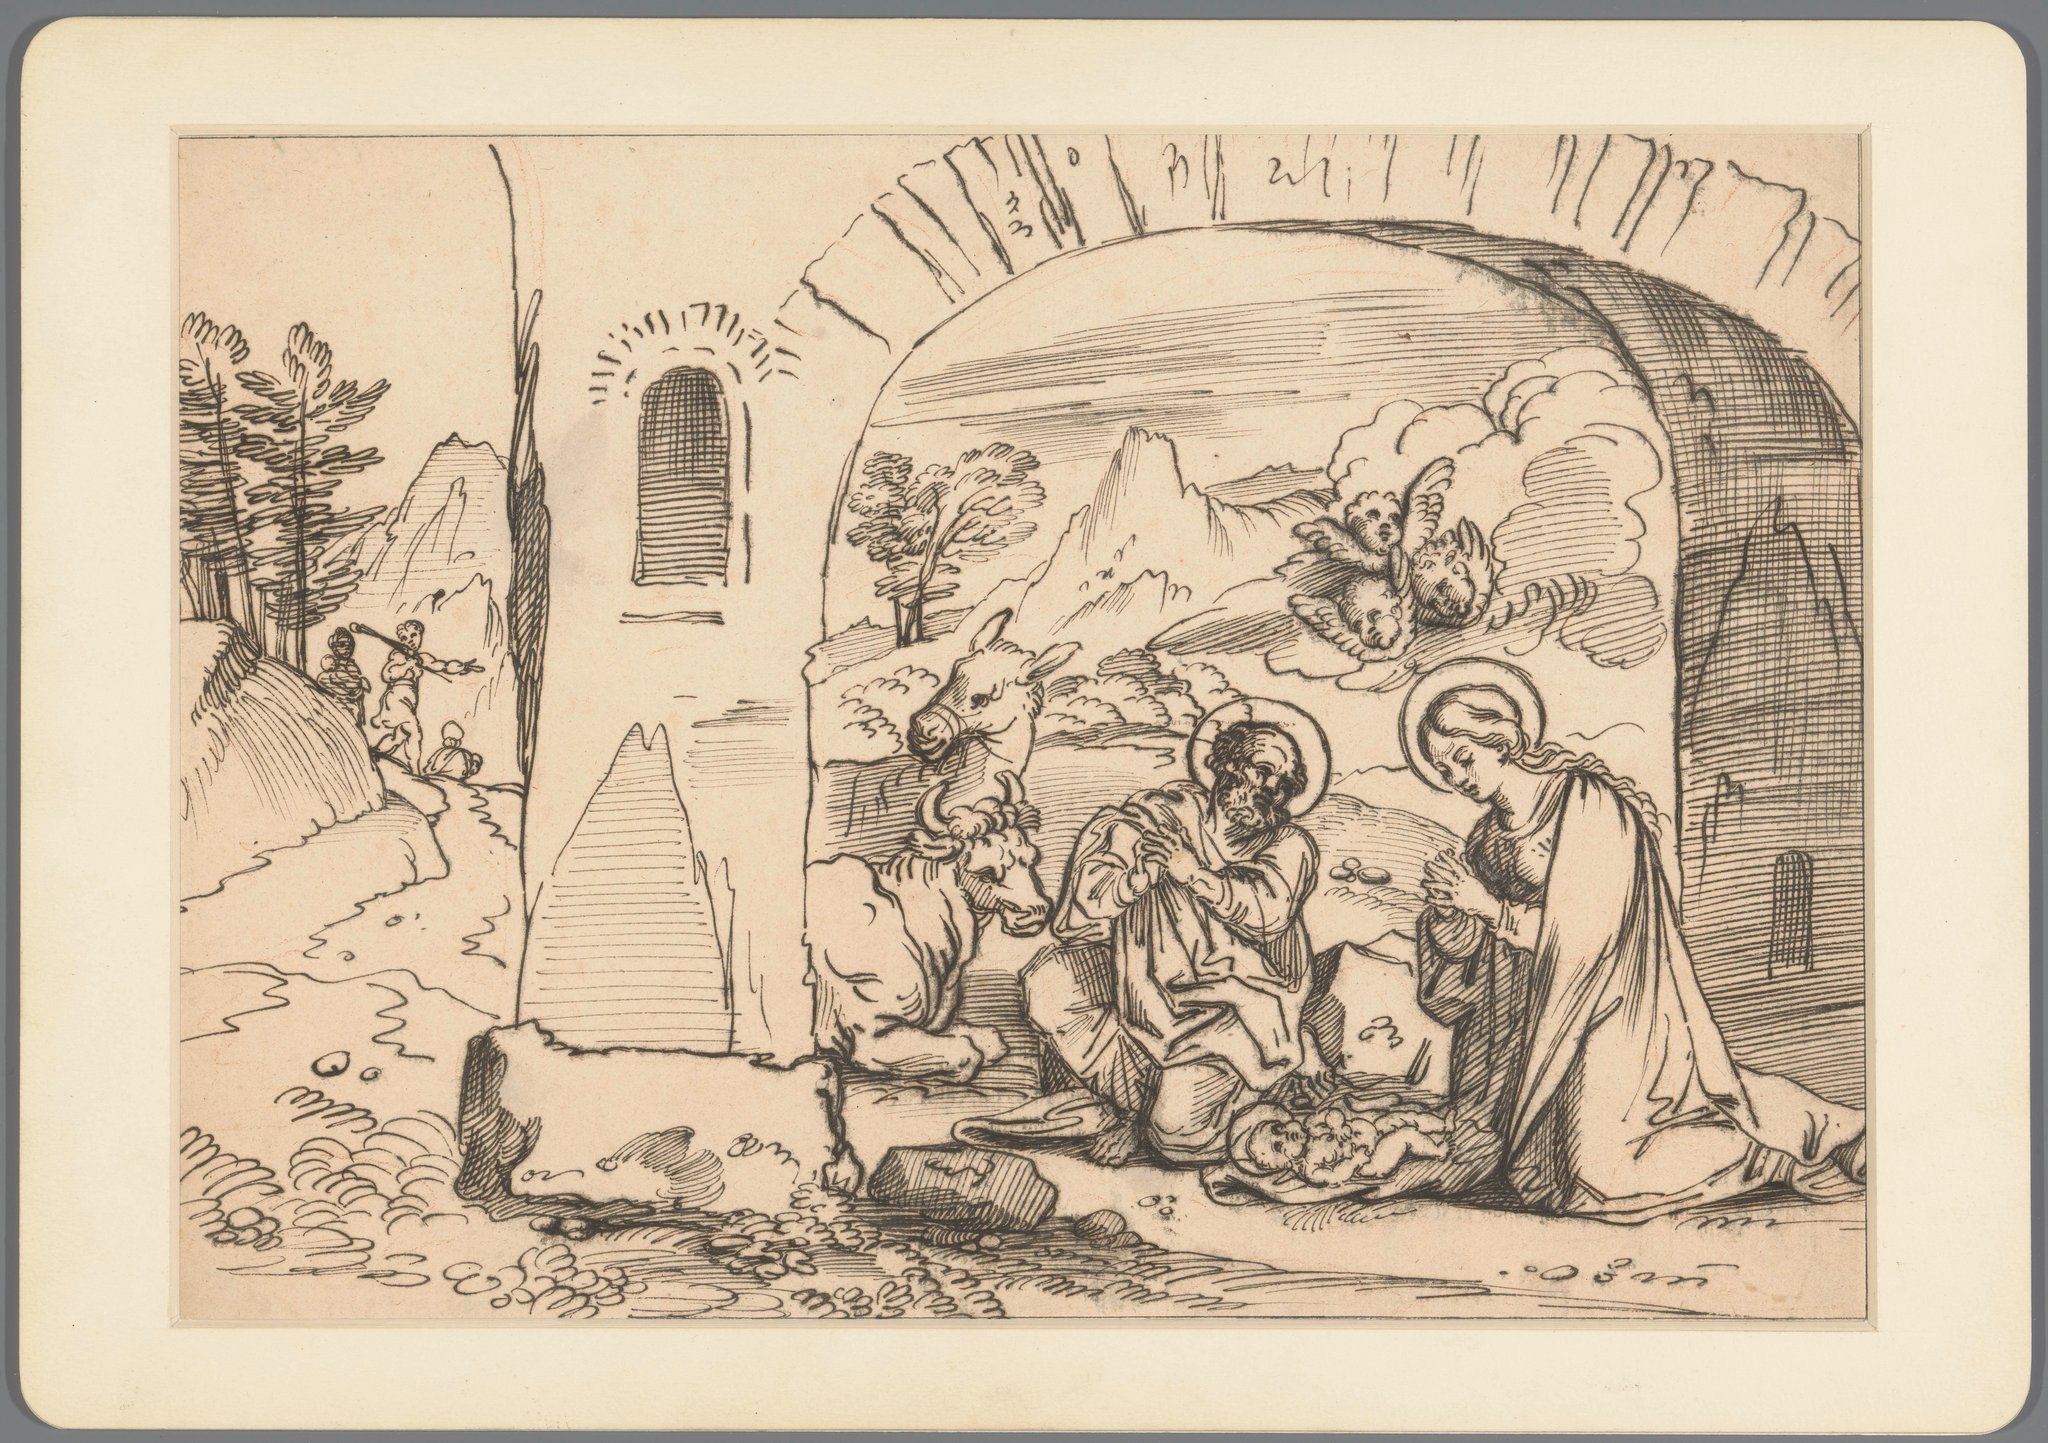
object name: drawing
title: De geboorte van Christus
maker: jean-baptiste corneille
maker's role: print maker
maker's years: 1649-1695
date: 1650-1700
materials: ink, paper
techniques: pen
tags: adoration of the christ-child by mary and joseph (+ angel(s))